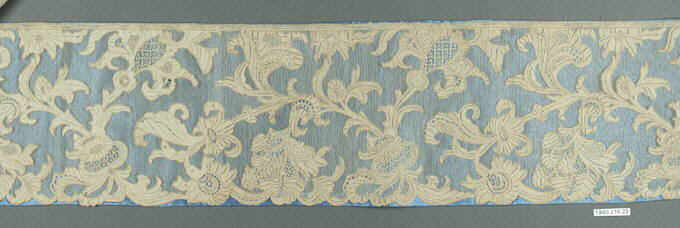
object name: edging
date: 1867-1900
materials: cotton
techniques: lace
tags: flowers